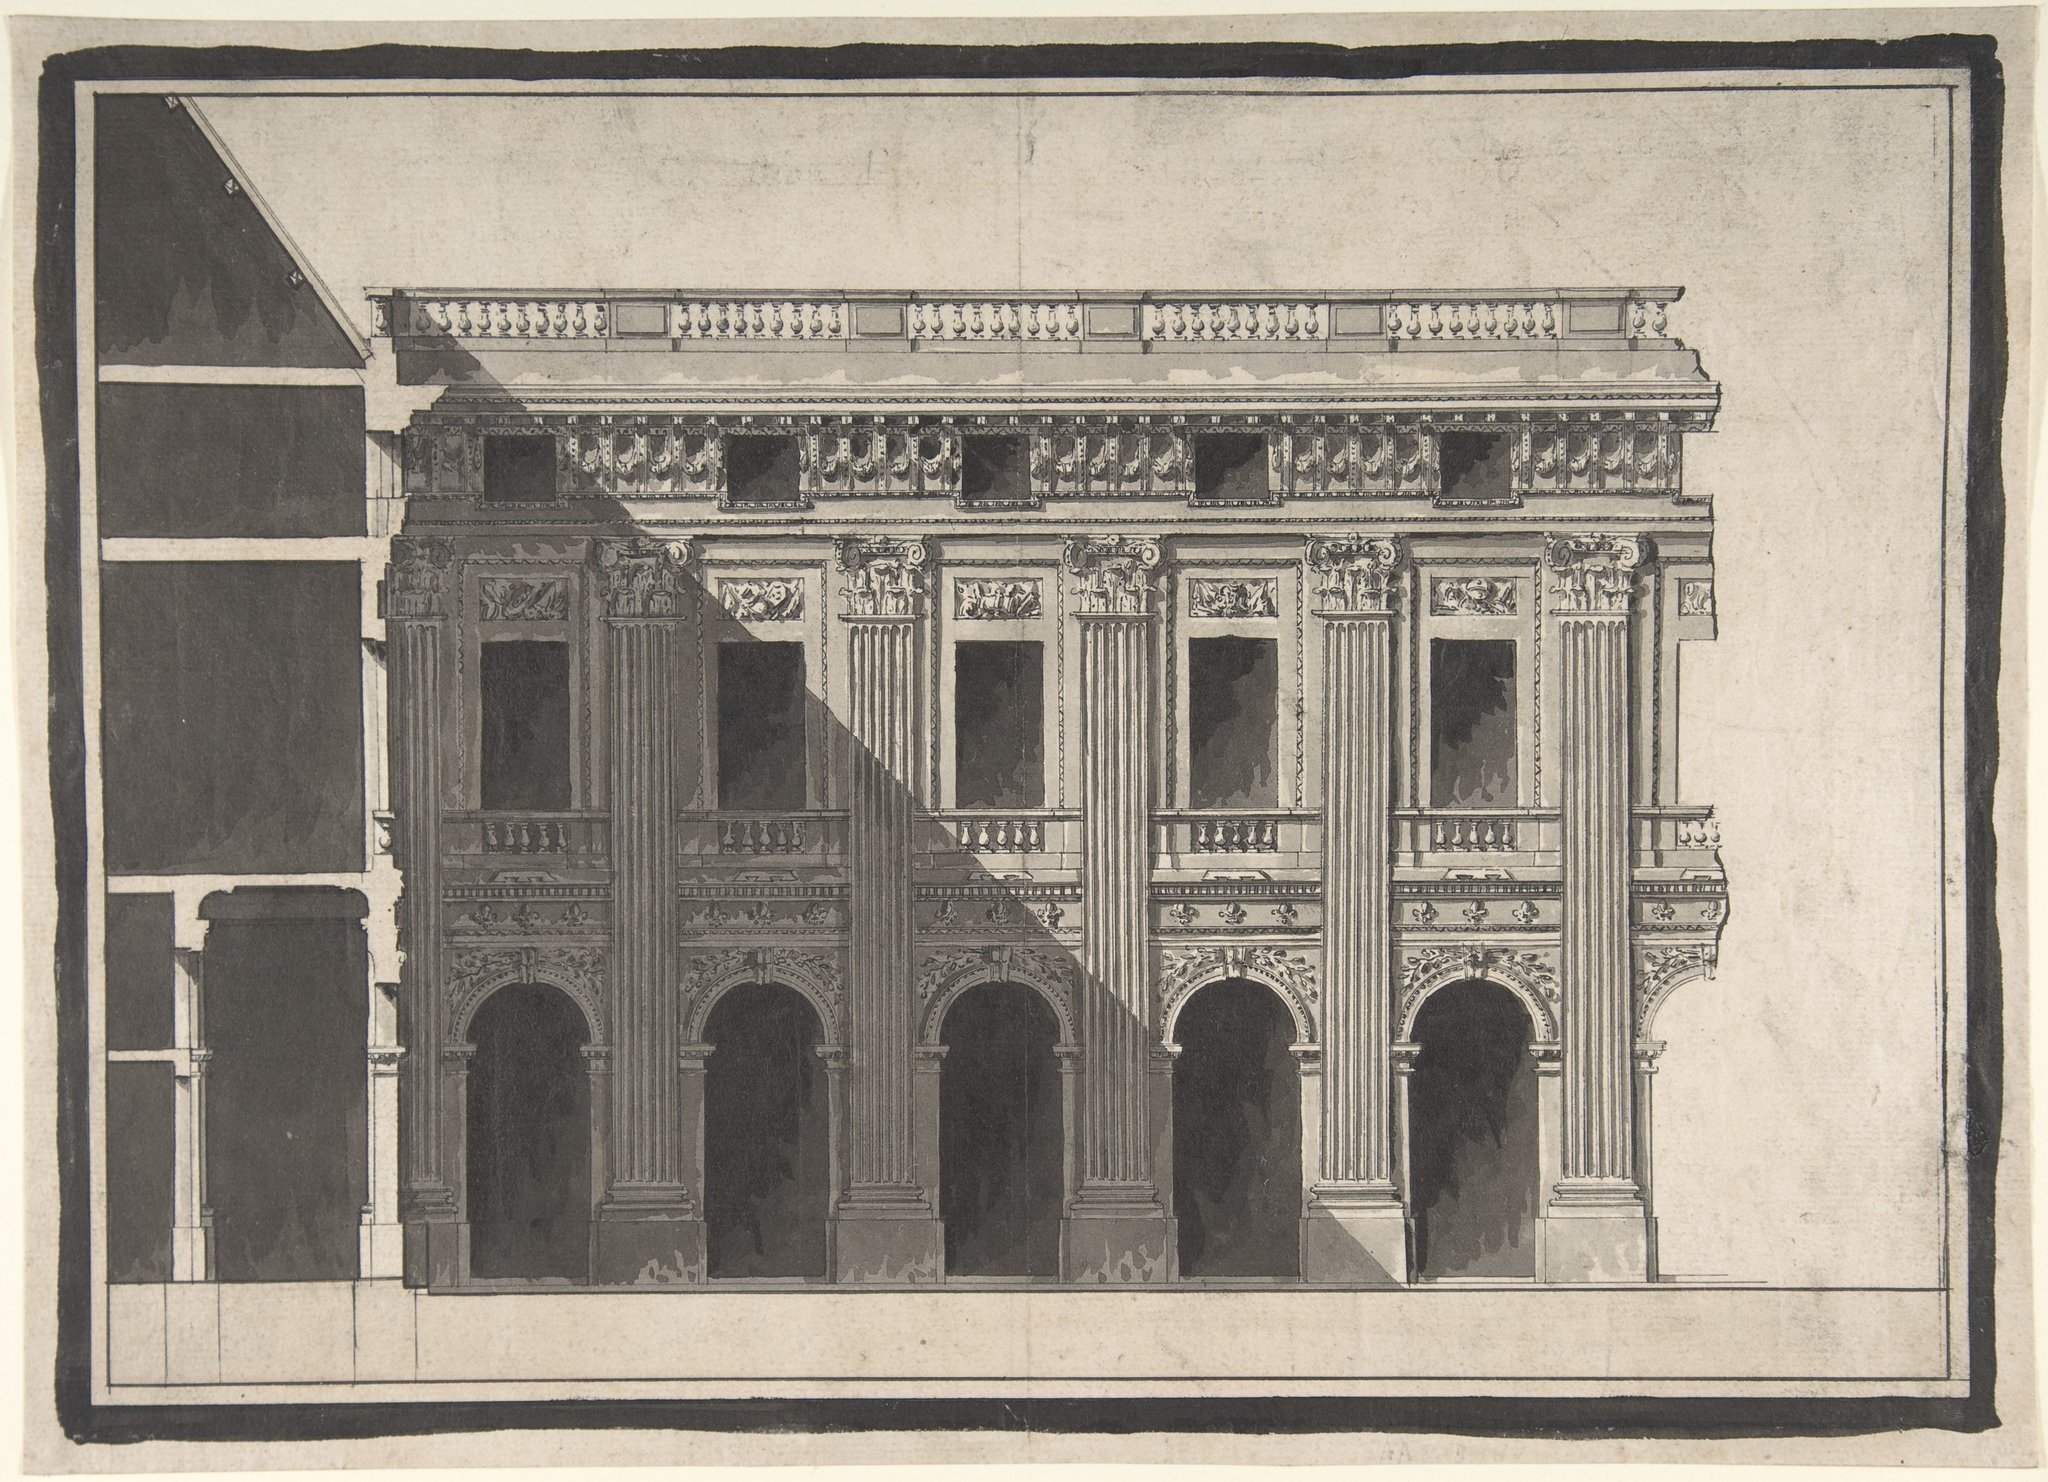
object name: drawing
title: Design for the Garden Façade of the Palais Royal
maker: victor louis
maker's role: artist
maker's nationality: french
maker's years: 1731-1800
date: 1781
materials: chalk, ink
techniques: brush, pen, drawing, wash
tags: architecture,buildings